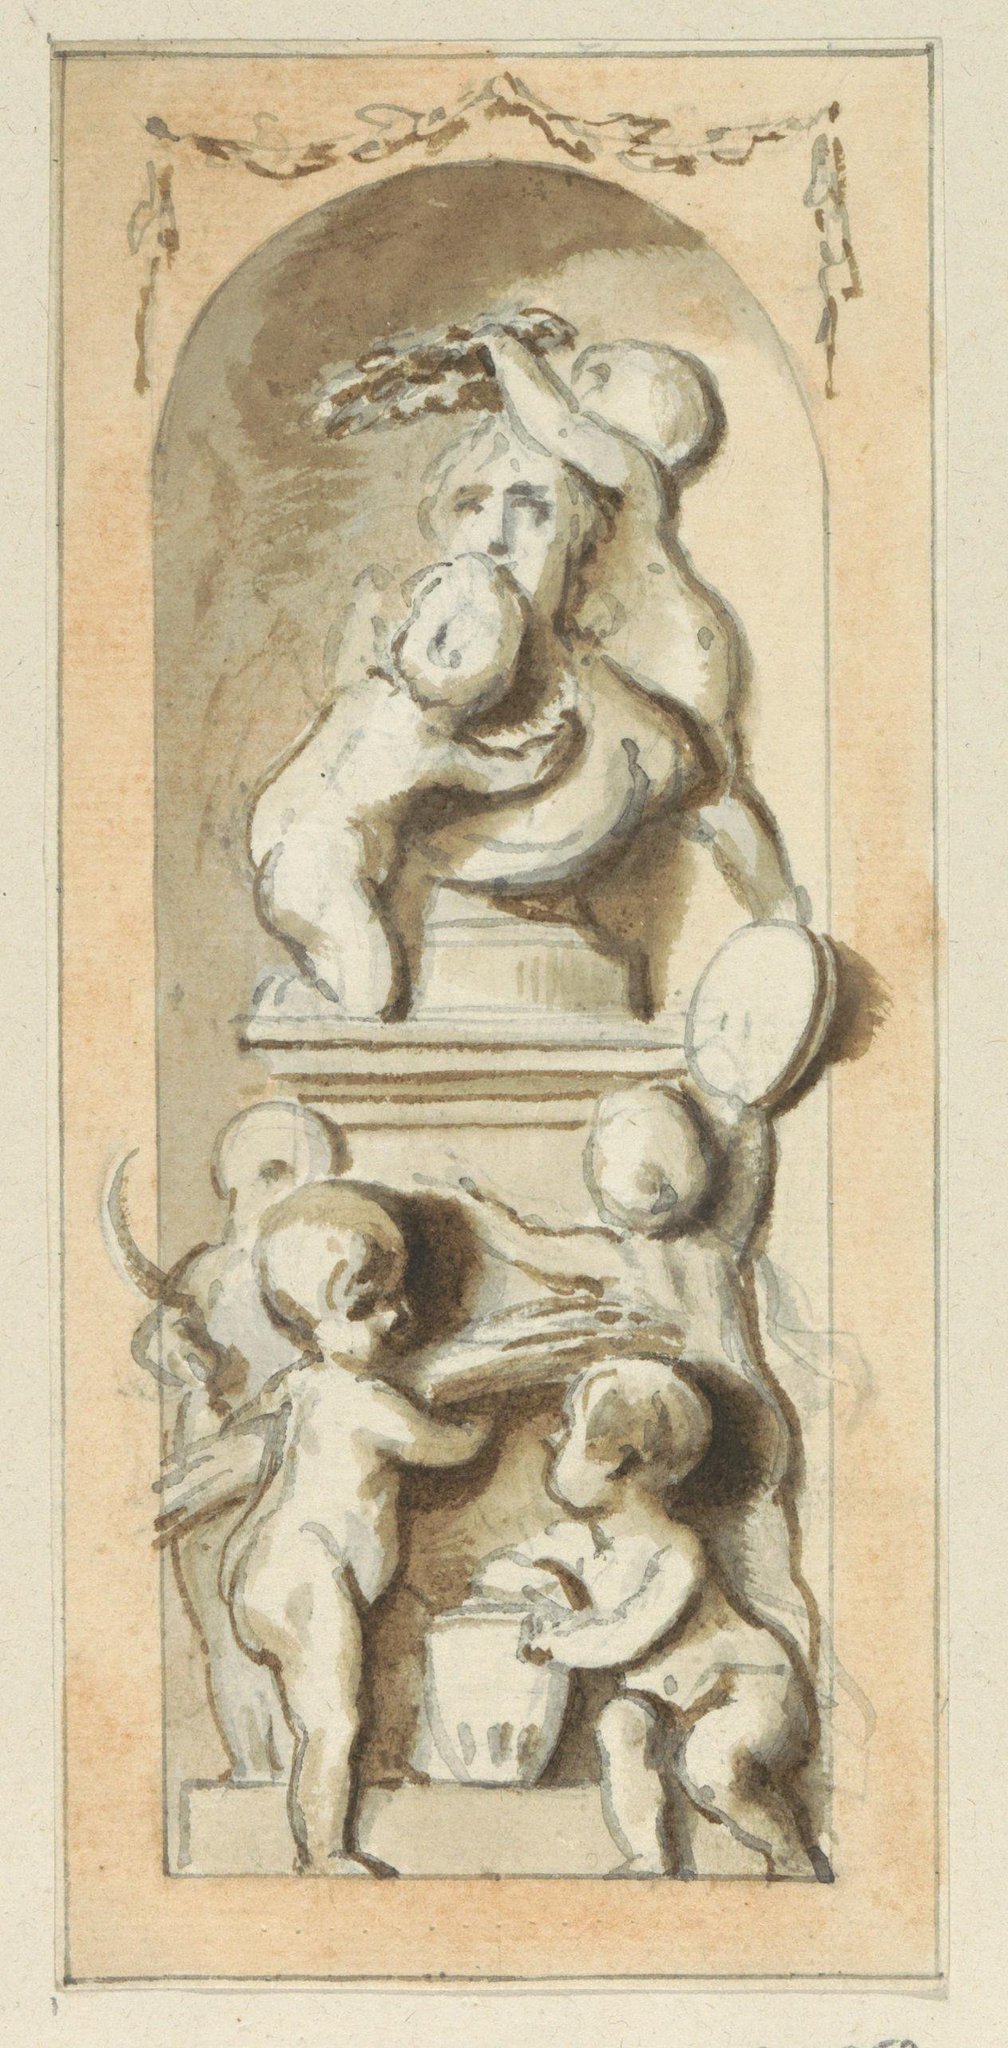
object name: drawing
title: Nis met putti die een buste lauweren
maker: jurriaan andriessen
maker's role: draughtsman, painter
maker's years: 1742-1819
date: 1760-1819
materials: paint, paper, pencil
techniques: brush, pen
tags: crowning with laurel, wall-covering, cupids: 'amores', 'amoretti', 'putti'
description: Mogelijk een ontwerp voor een wanddecoratie. Tekening maakt deel uit van een album.